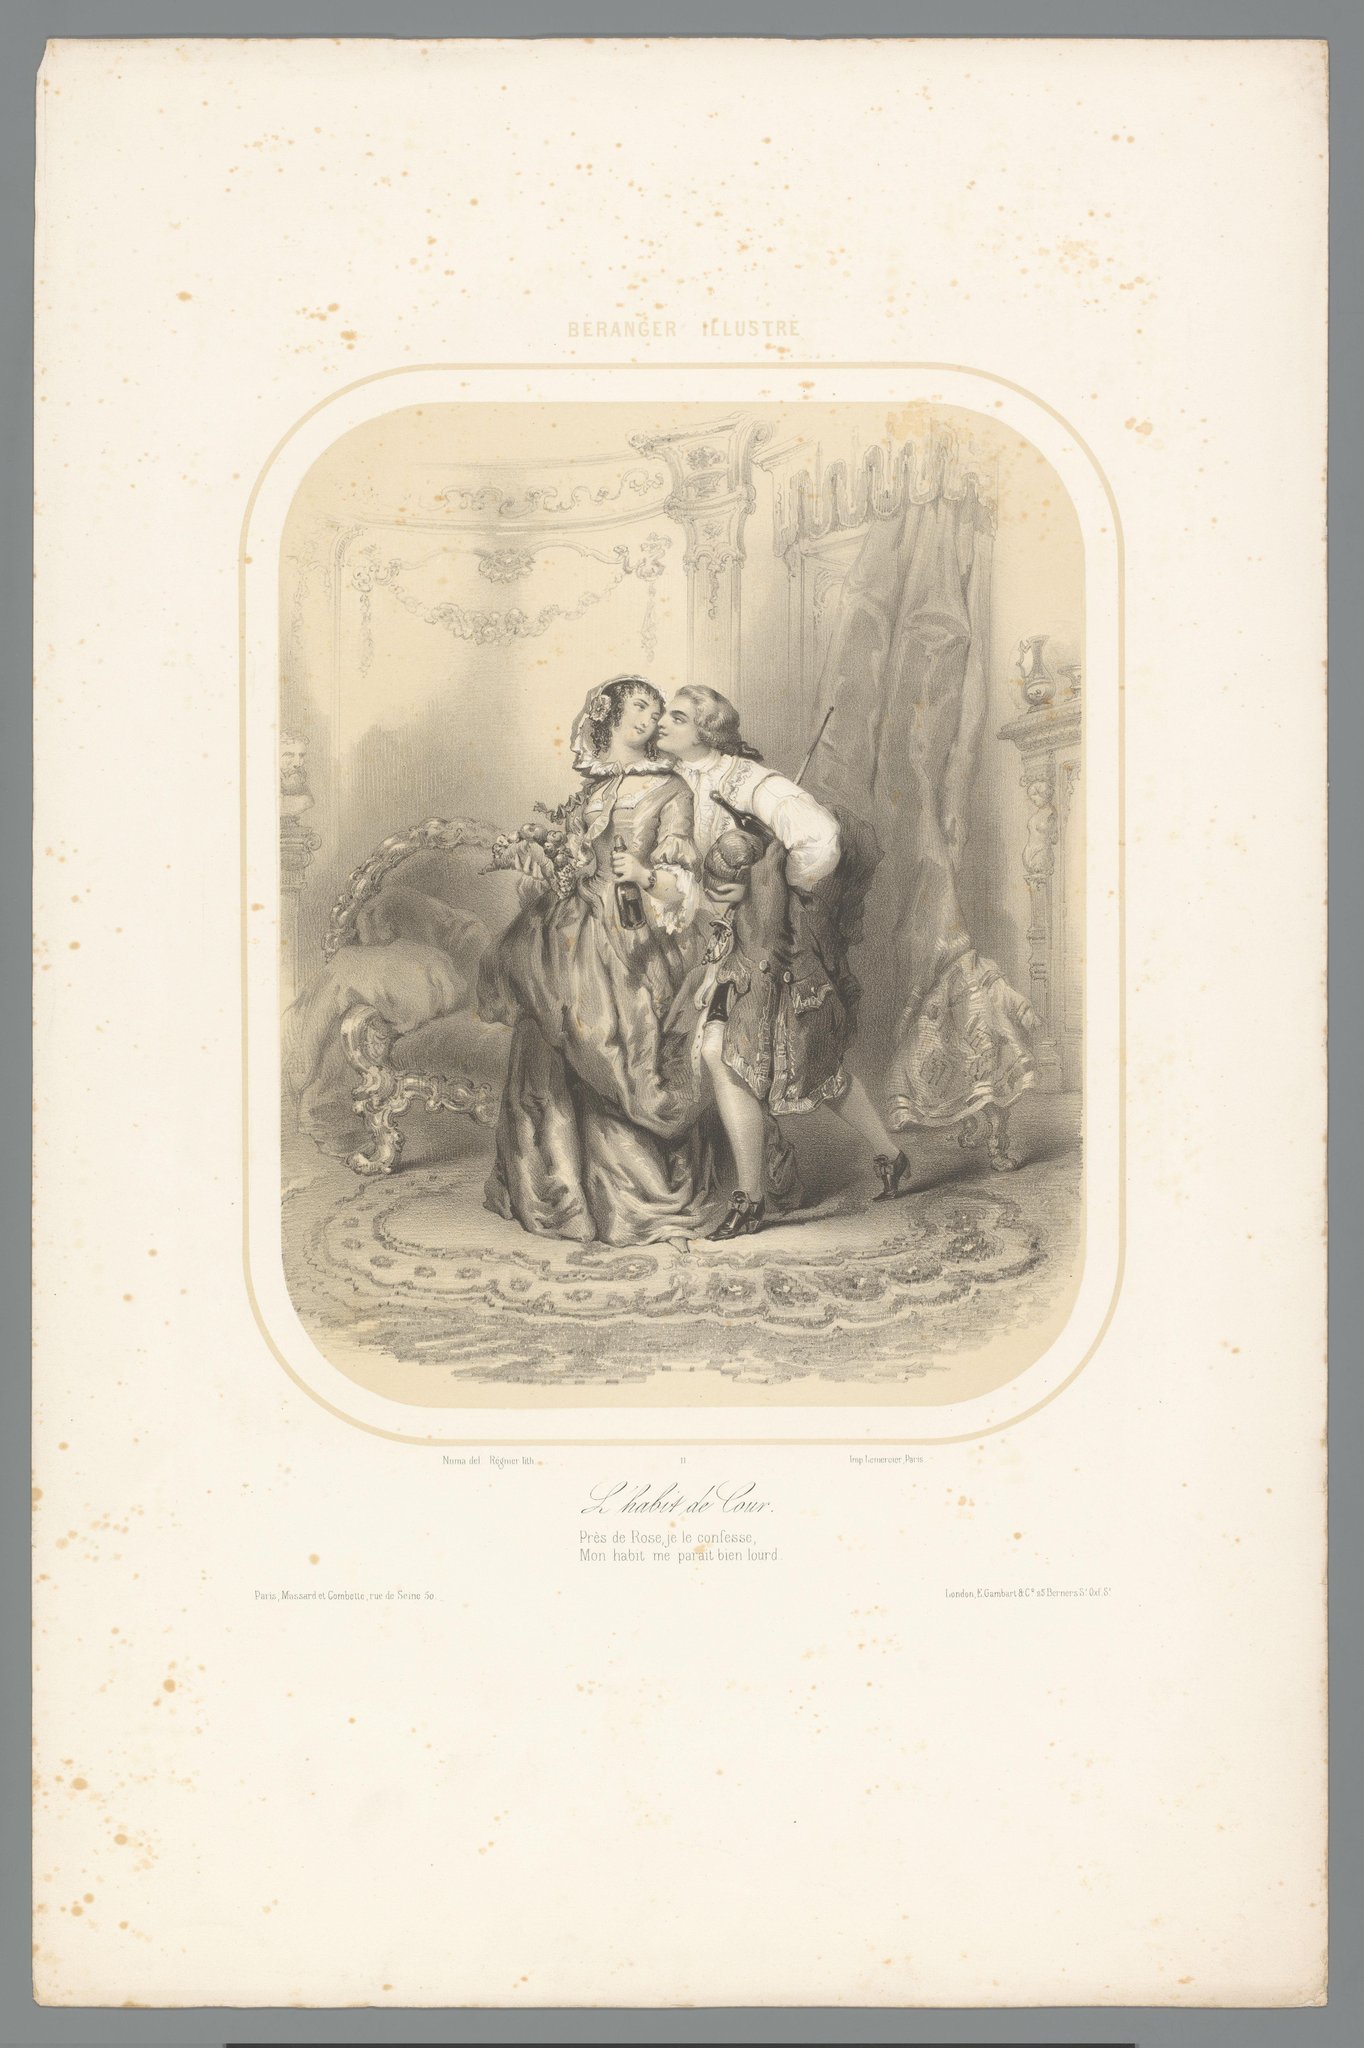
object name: print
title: Geïllustreerde gedichten van Pierre-Jean de Béranger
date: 1851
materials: paper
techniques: tone lithography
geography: paris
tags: couple of lovers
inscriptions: collector's mark: Lugt 2228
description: Onderschrift: Près de Rose, je le confesse, mon habit me parait bien lourd.